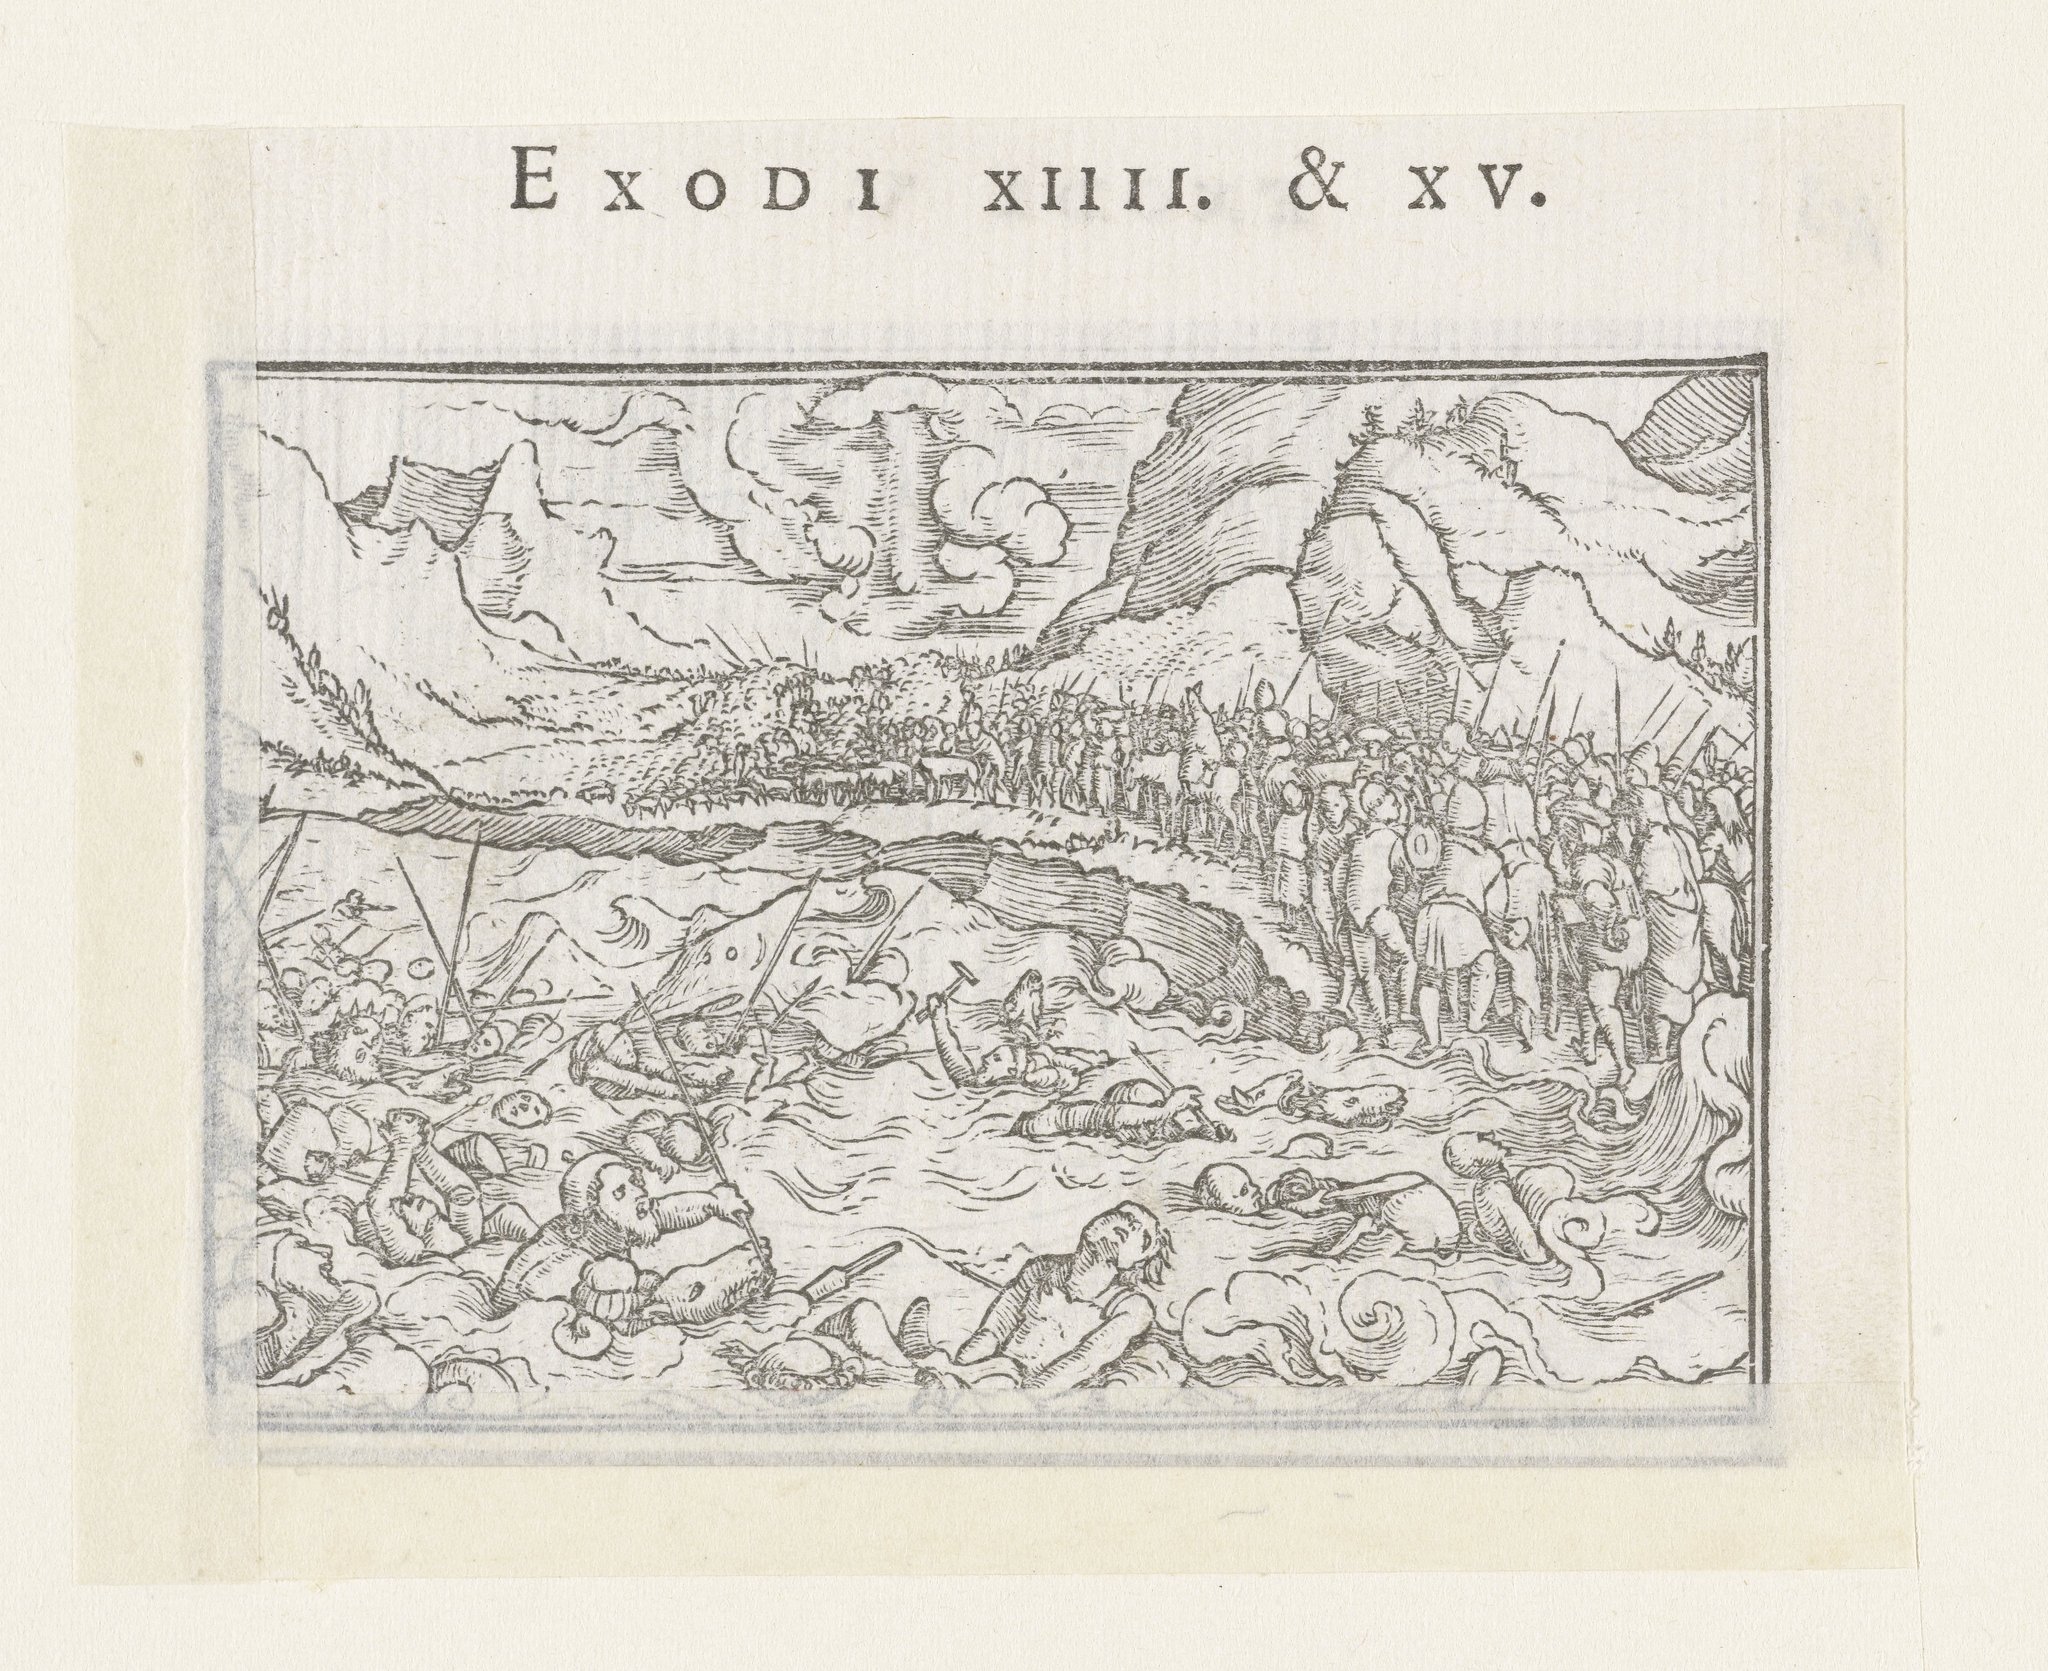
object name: print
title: Vernietiging van legers van Farao in Rode Zee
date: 1538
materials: paper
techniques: woodcut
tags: with his people safe on the shore, moses raises his hands and causes the water to return; pharaoh's army perishes in the water (red sea)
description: Houtblok voor het eerst gebruikt in: Biblia Utriusque Testamenti iuxta Vulgatam Translationem, Lyon, M. en G. Trechsel (voor Hugo à Porta) 1538. Later in verschillende uitgaven opnieuw gebruikt.